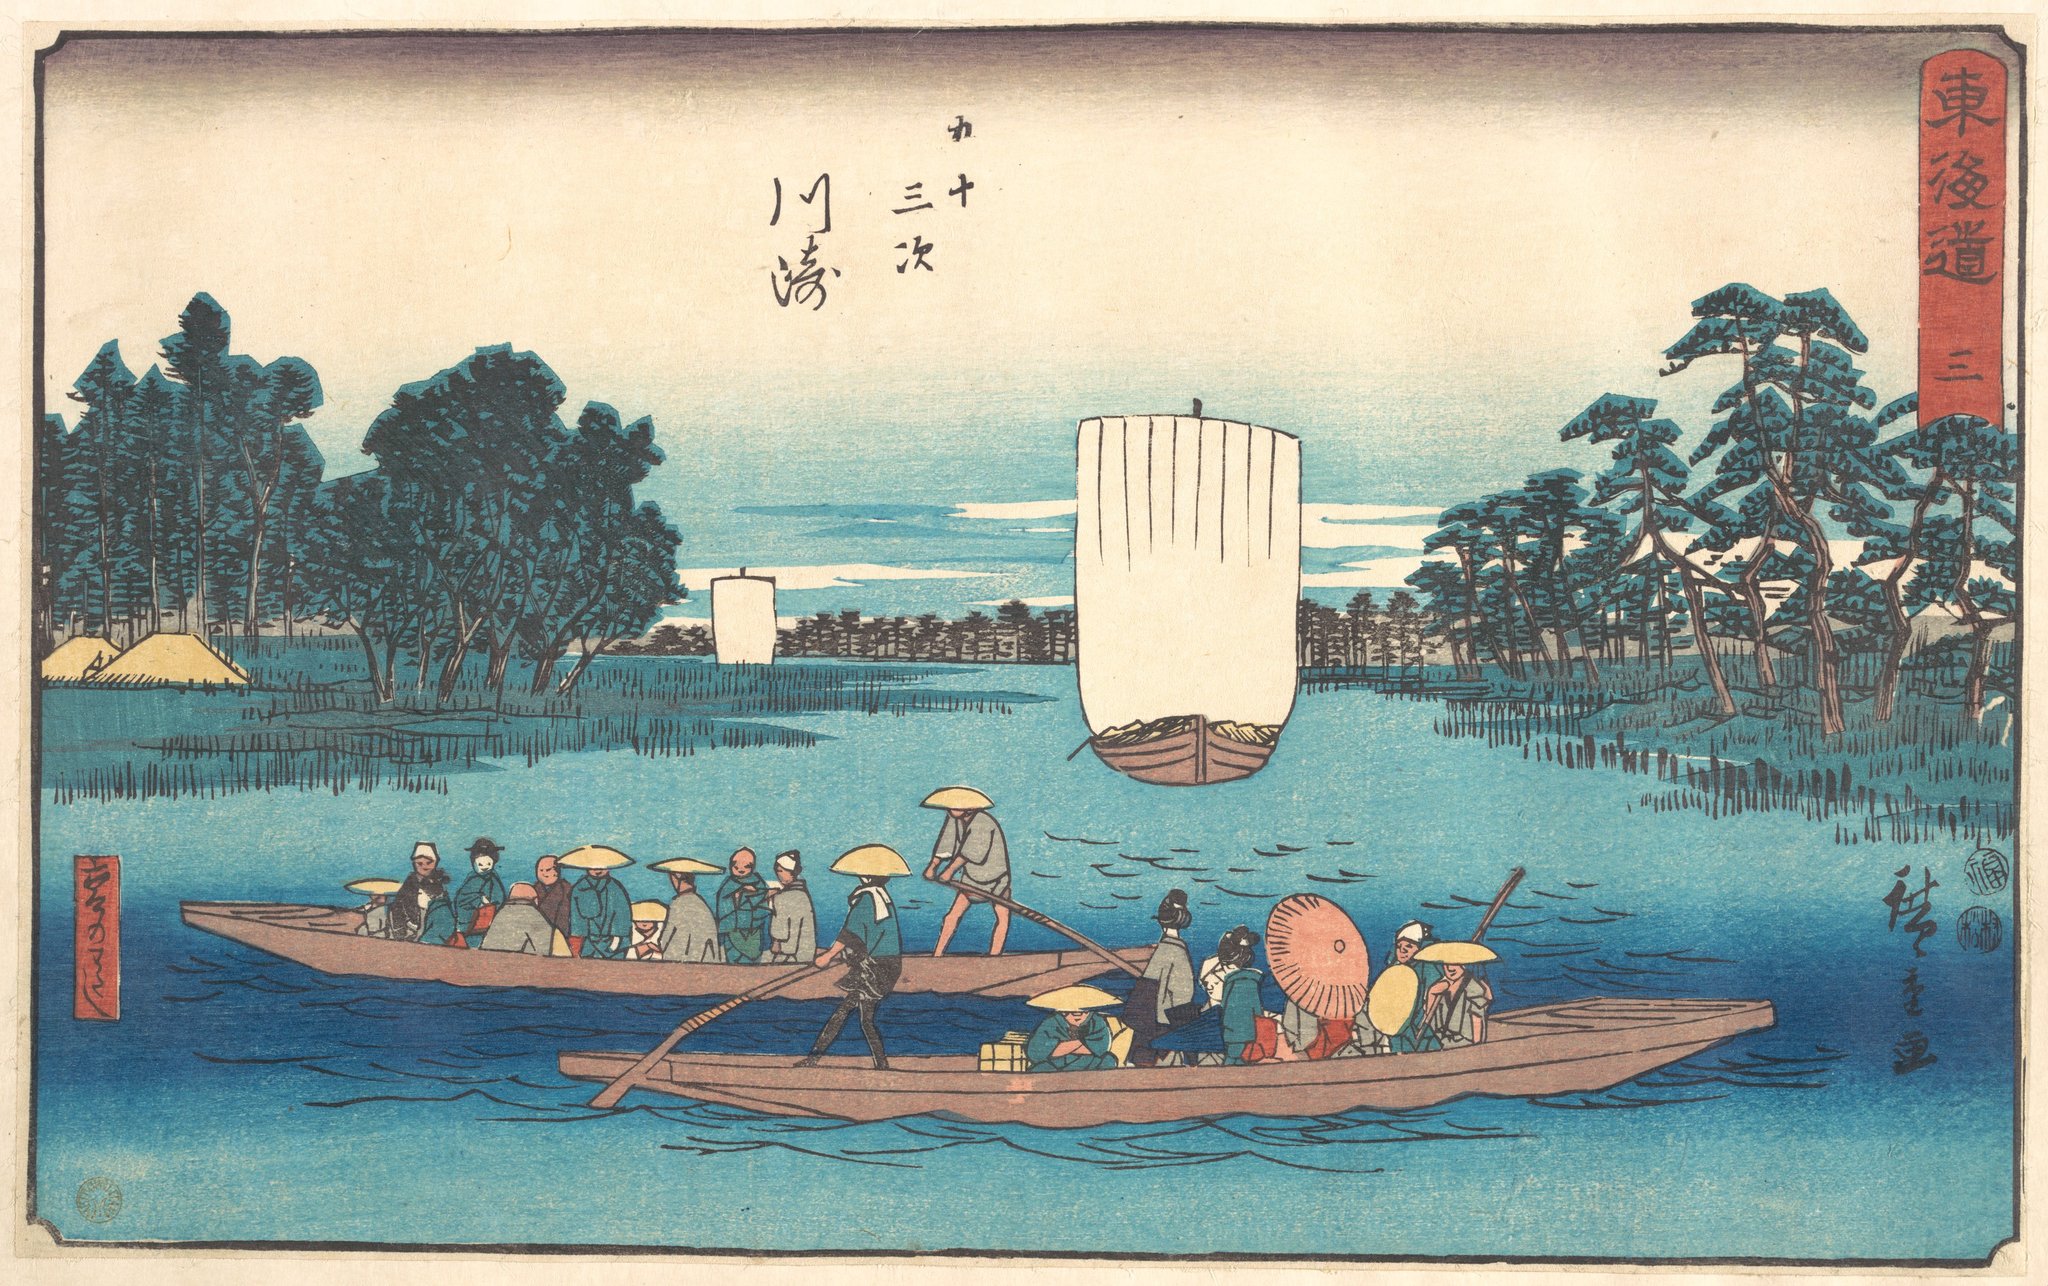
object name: print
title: Kawasaki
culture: japanese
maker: utagawa hiroshige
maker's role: artist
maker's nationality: japanese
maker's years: 1797-1858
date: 1840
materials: ink, paper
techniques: woodblock print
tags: boats